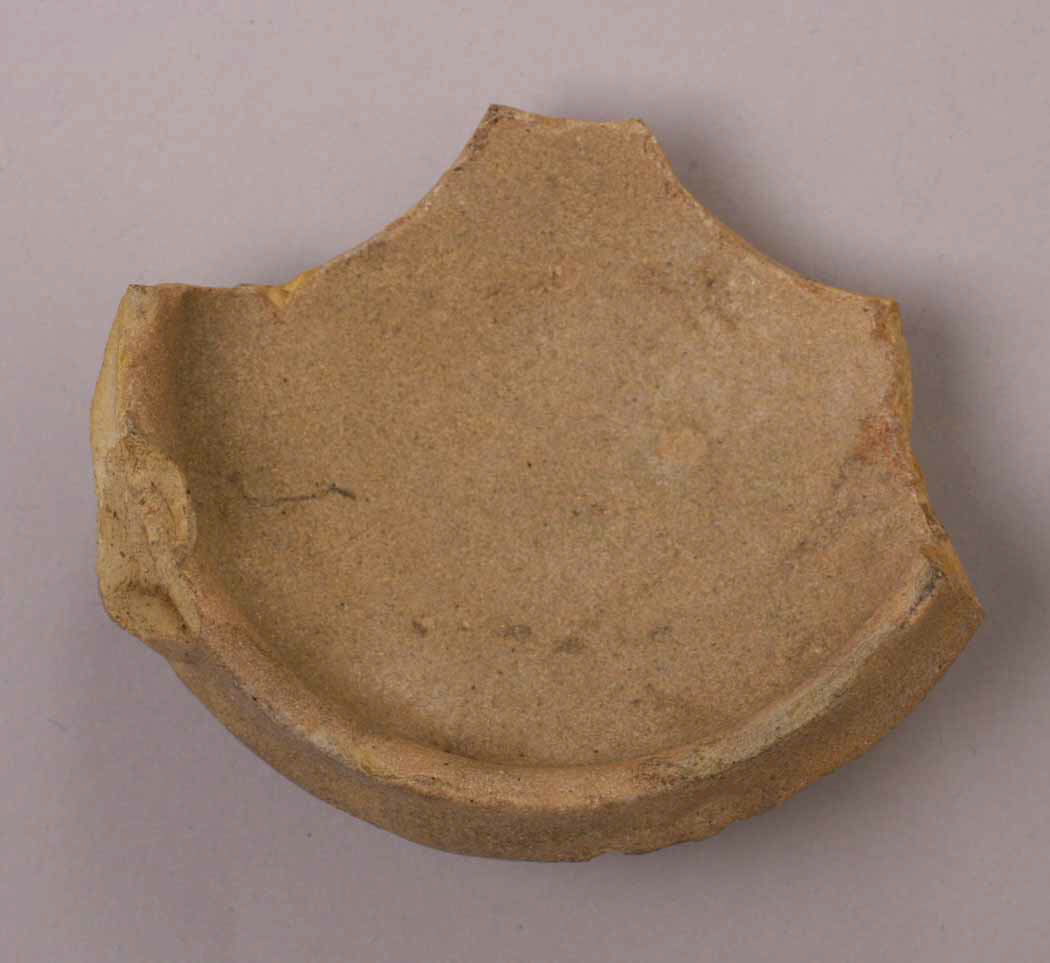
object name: fragment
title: Ceramic Fragment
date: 701-800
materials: earthenware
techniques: glazing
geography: iraq